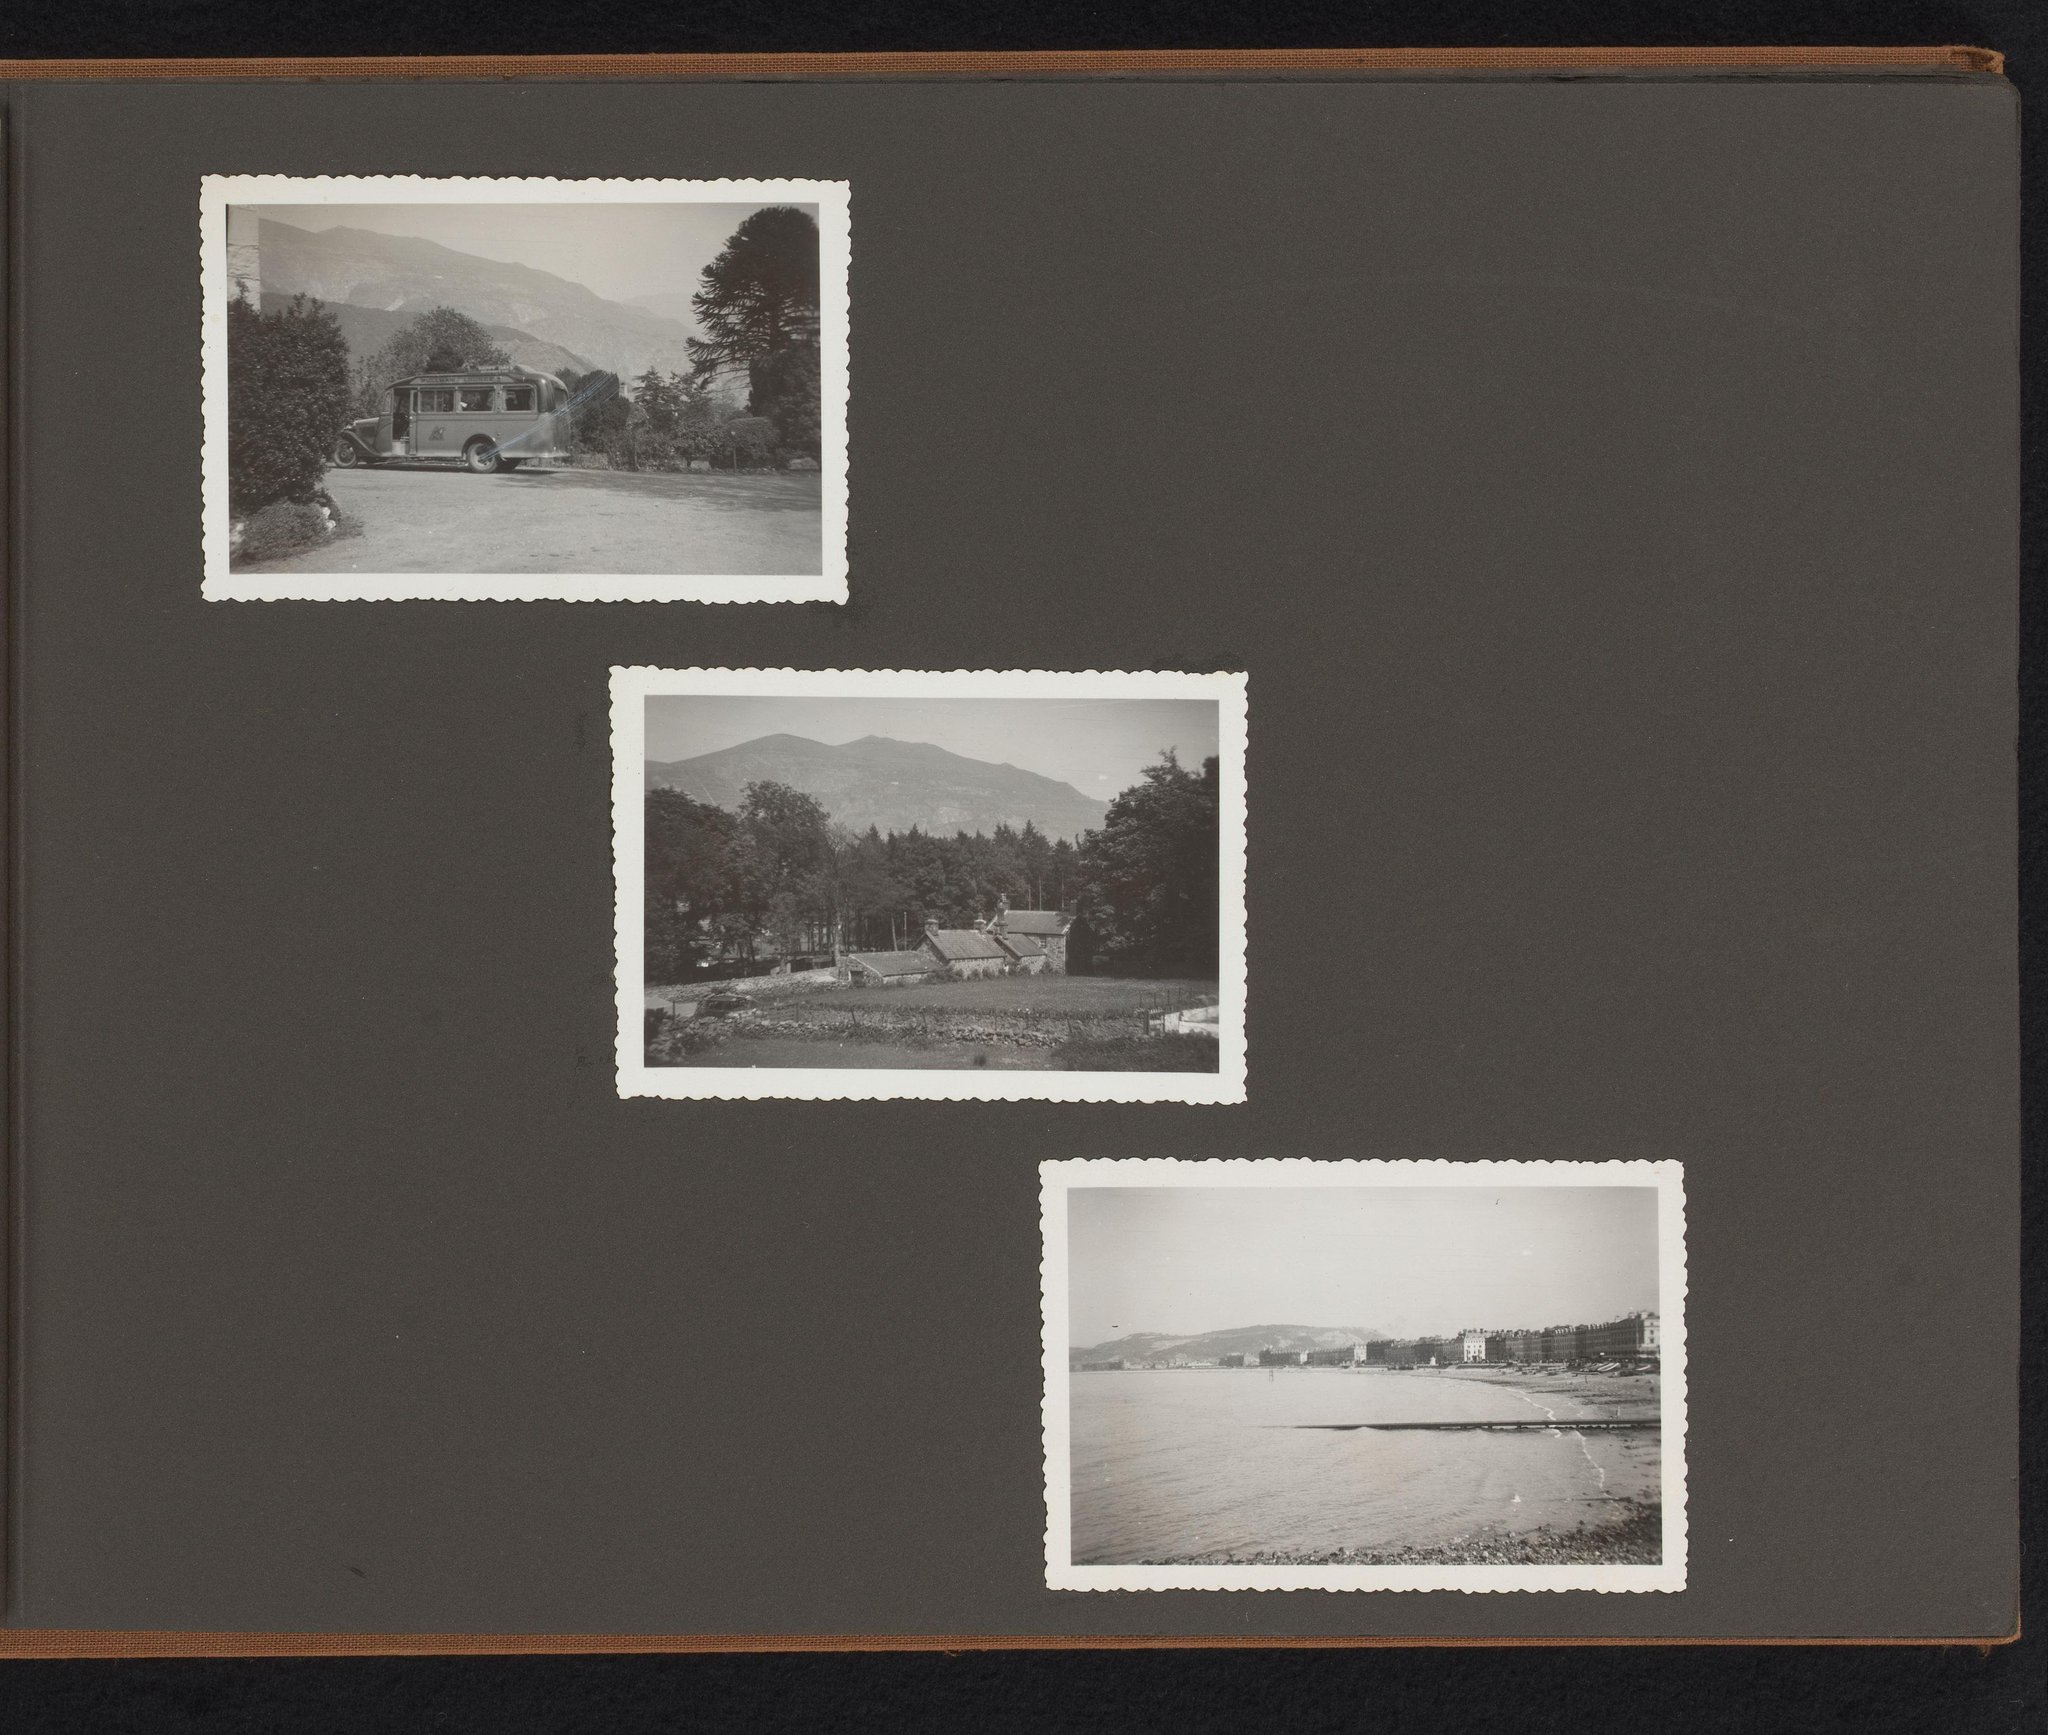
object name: photograph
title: Echtpaar Berti Hoppe en Herman Besselaar op vakantie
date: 1936-1939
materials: cardboard, paper, photographic support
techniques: gelatin silver print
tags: city-view in general; 'veduta', mountains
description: Twee landschappen met bergen en een kustplaats, genomen tijdens een vakantie van Berti Hoppe en Herman Besselaar. Deze pagina maakt deel uit van een album.